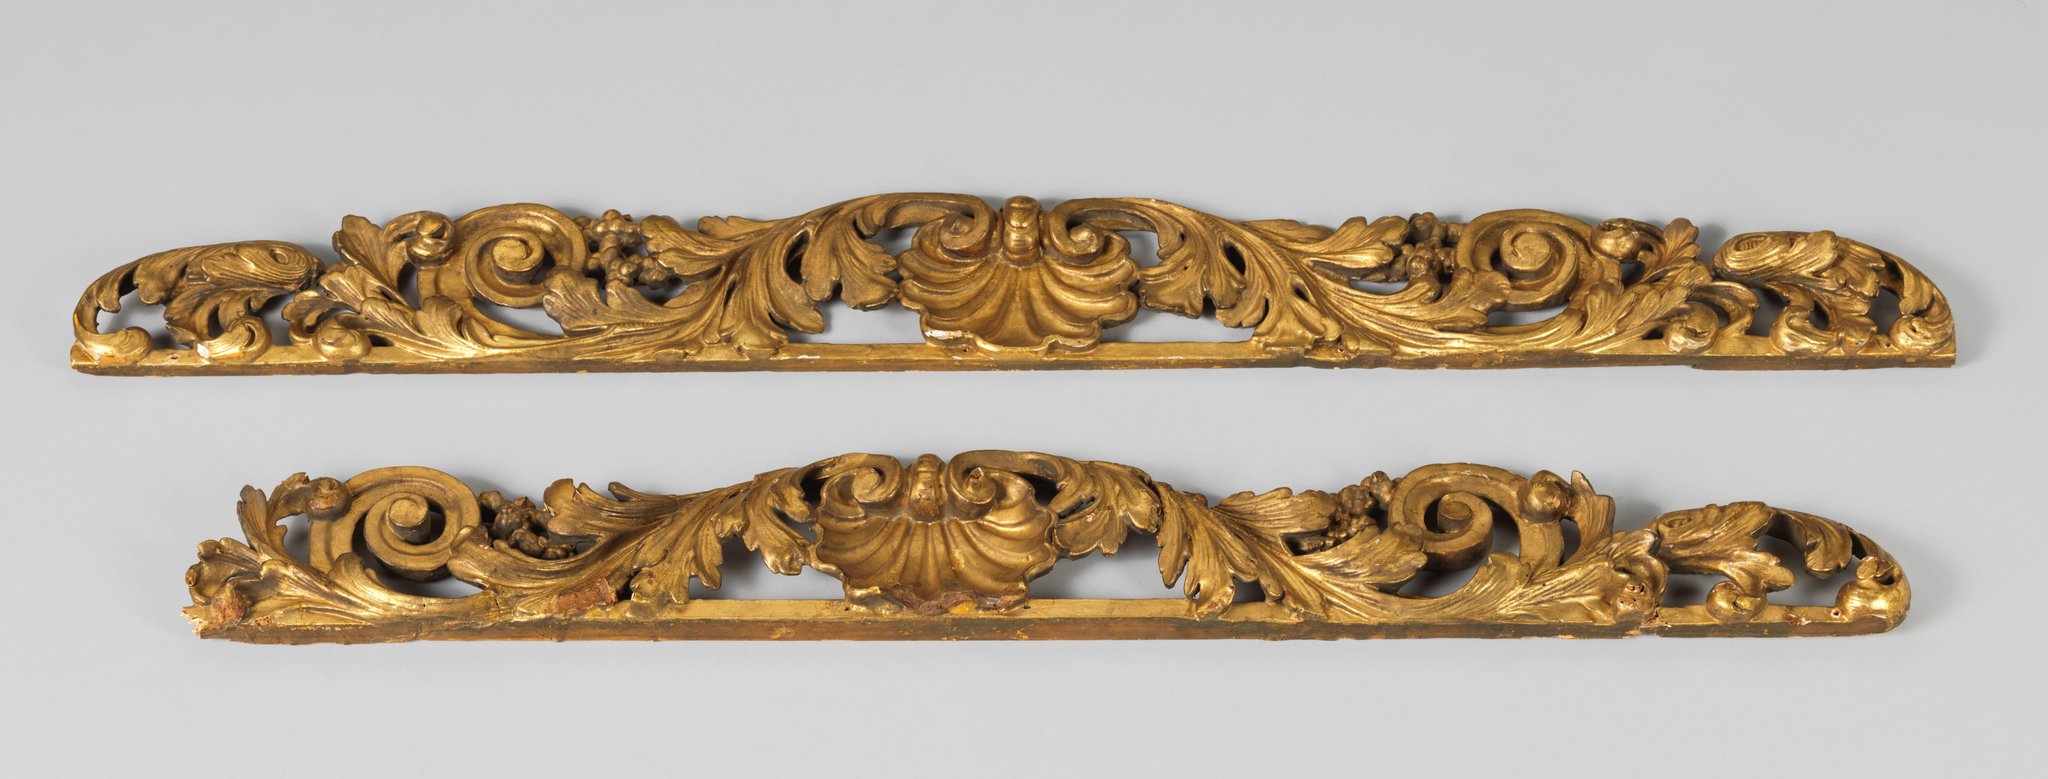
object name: table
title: Twee regels van gebeeldhouwd en verguld lindehout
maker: Anonymous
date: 1689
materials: wood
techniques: gilding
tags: ram's head ~ ornament, ornament ~ festoon, garland, cupids: 'amores', 'amoretti', 'putti', flowers ~ ornament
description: Twee onderdelen horend bij tafel BK-1962-49.